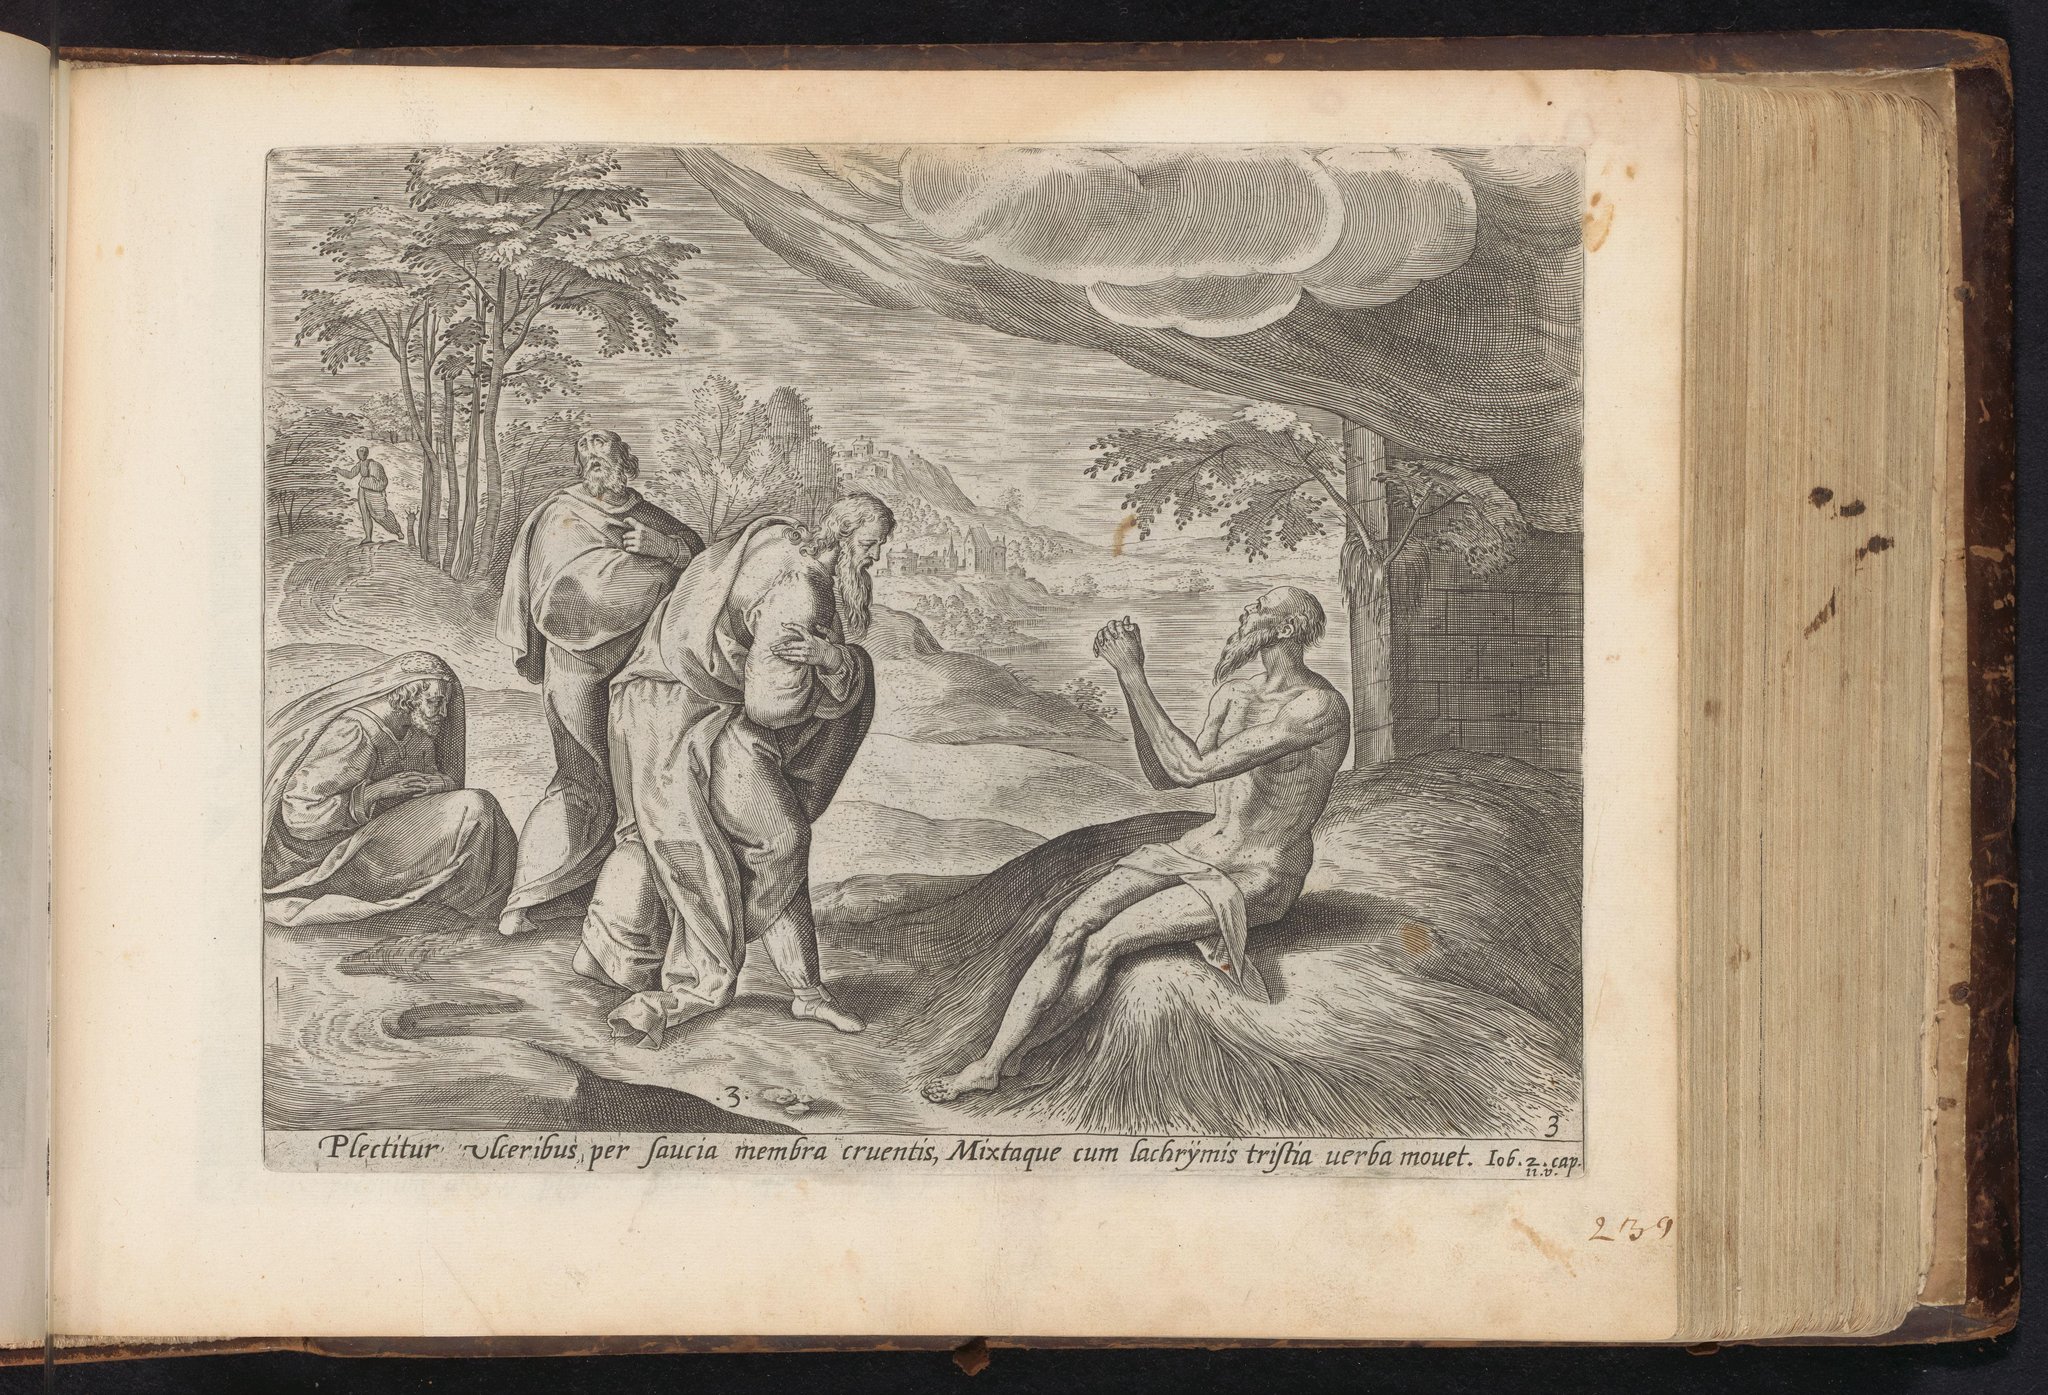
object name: album leaf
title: Job op de mesthoop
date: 1579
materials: paper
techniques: engraving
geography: alkmaar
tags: job on the dunghill visited by his friends (and wife)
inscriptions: number: ‘239’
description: Job zit op een mesthoop en wordt bezocht en bespot door zijn vrienden. Een van zijn vrienden zit in zak en as: hij heeft as op zijn hoofd gestrooid. Onder de voorstelling een verwijzing in het Latijn naar de Bijbeltekst in Job 2:11. Deze prent maakt deel uit van een album.